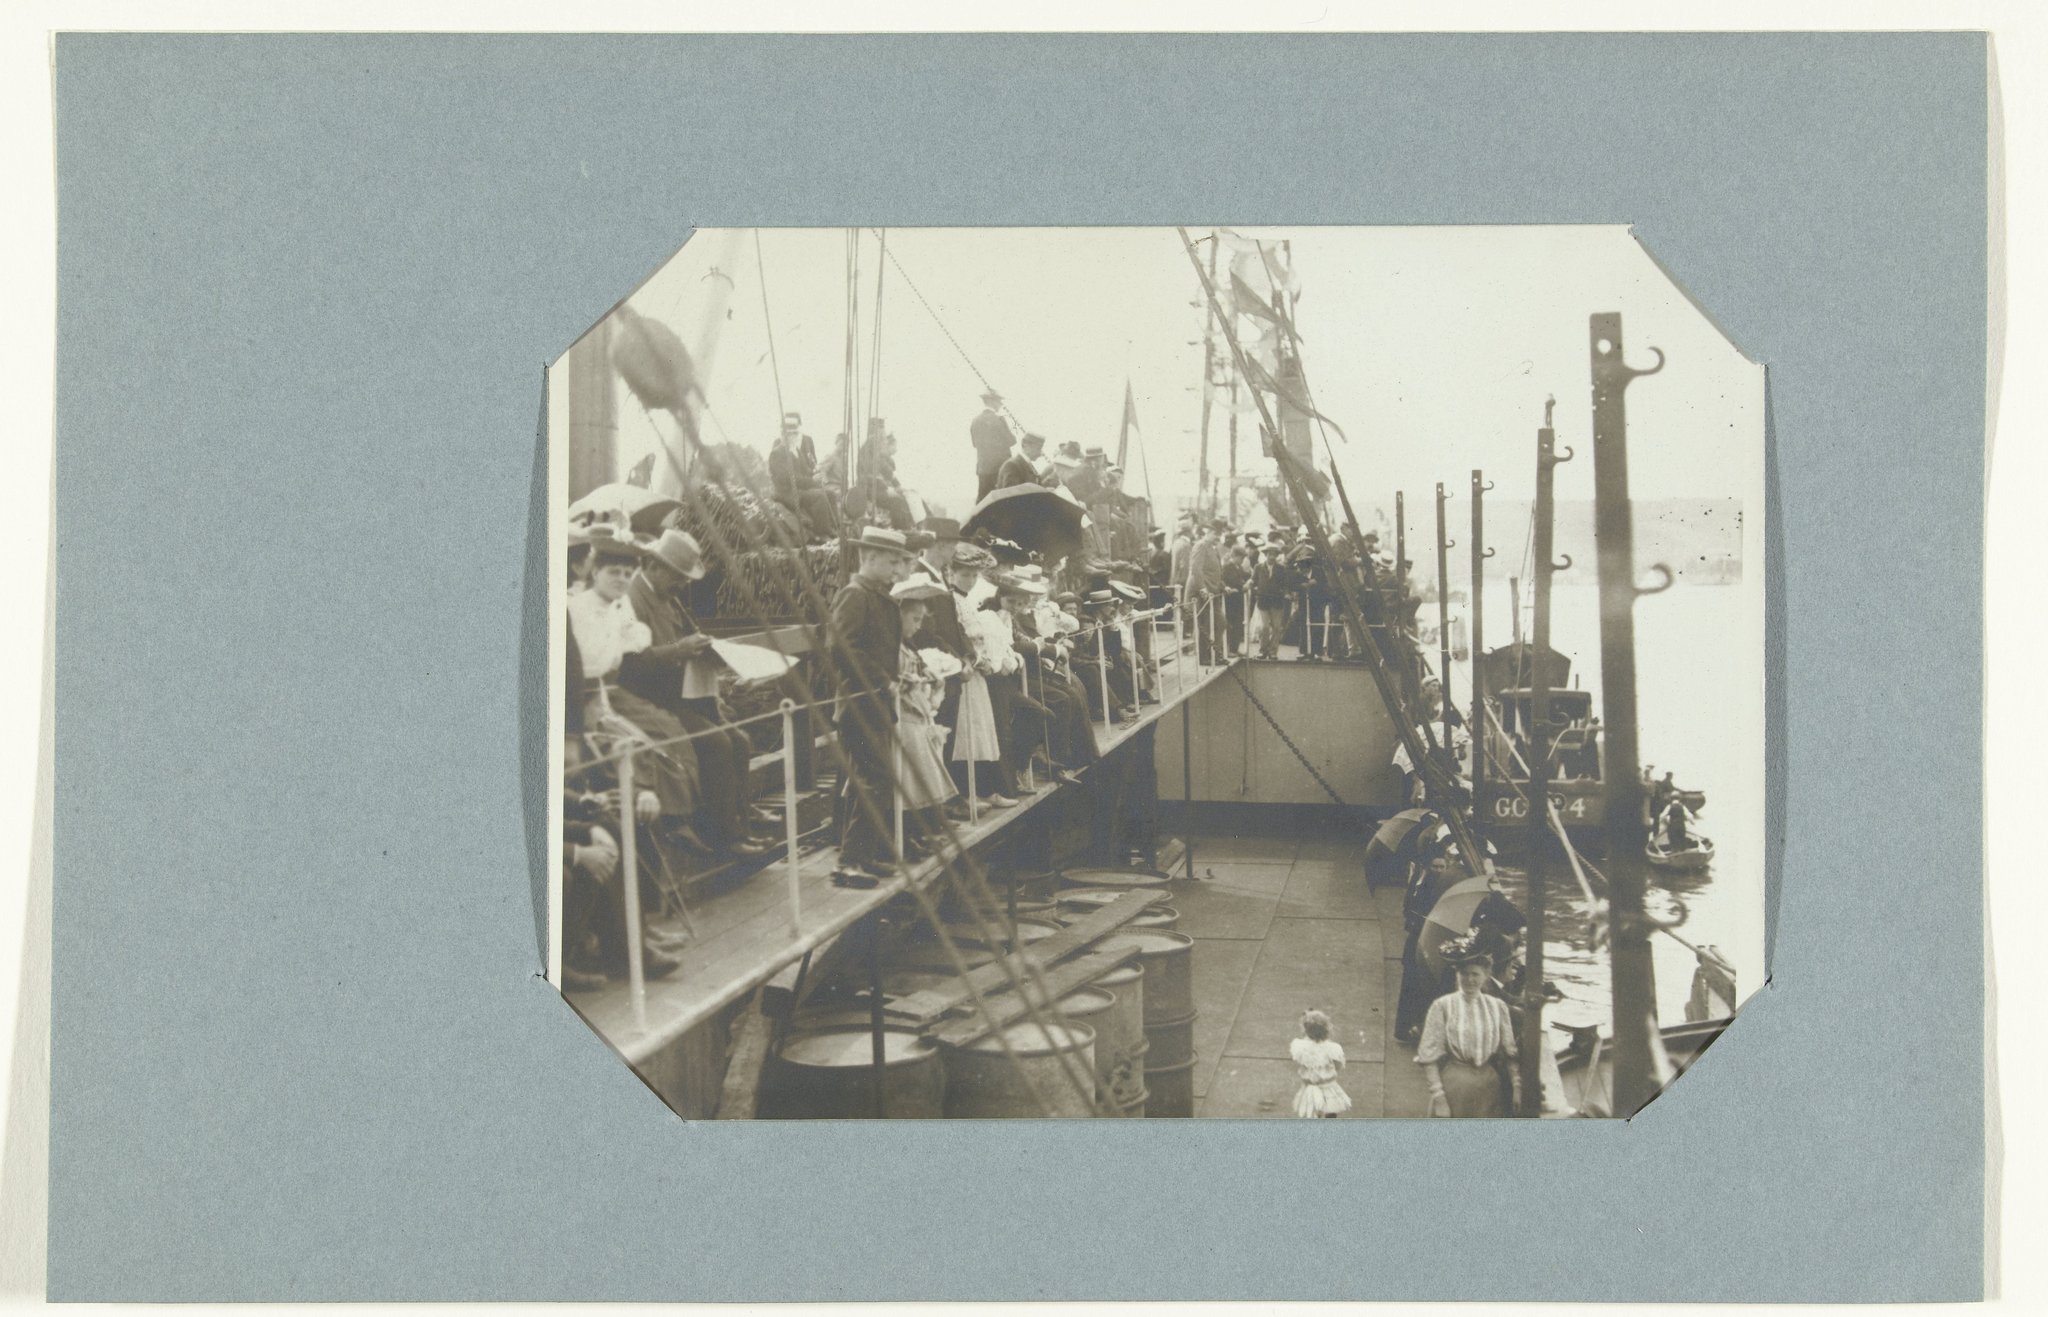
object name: photograph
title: Publiek aan boord van een schip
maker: Anonymous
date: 1905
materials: paper, cardboard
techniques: gelatin silver print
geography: france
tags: passengers ~ ship, france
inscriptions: date: ‘6 aout/ 1905’, inscription: ‘Catalog/ 772/ Guillement/ 10"’, number: ‘30’